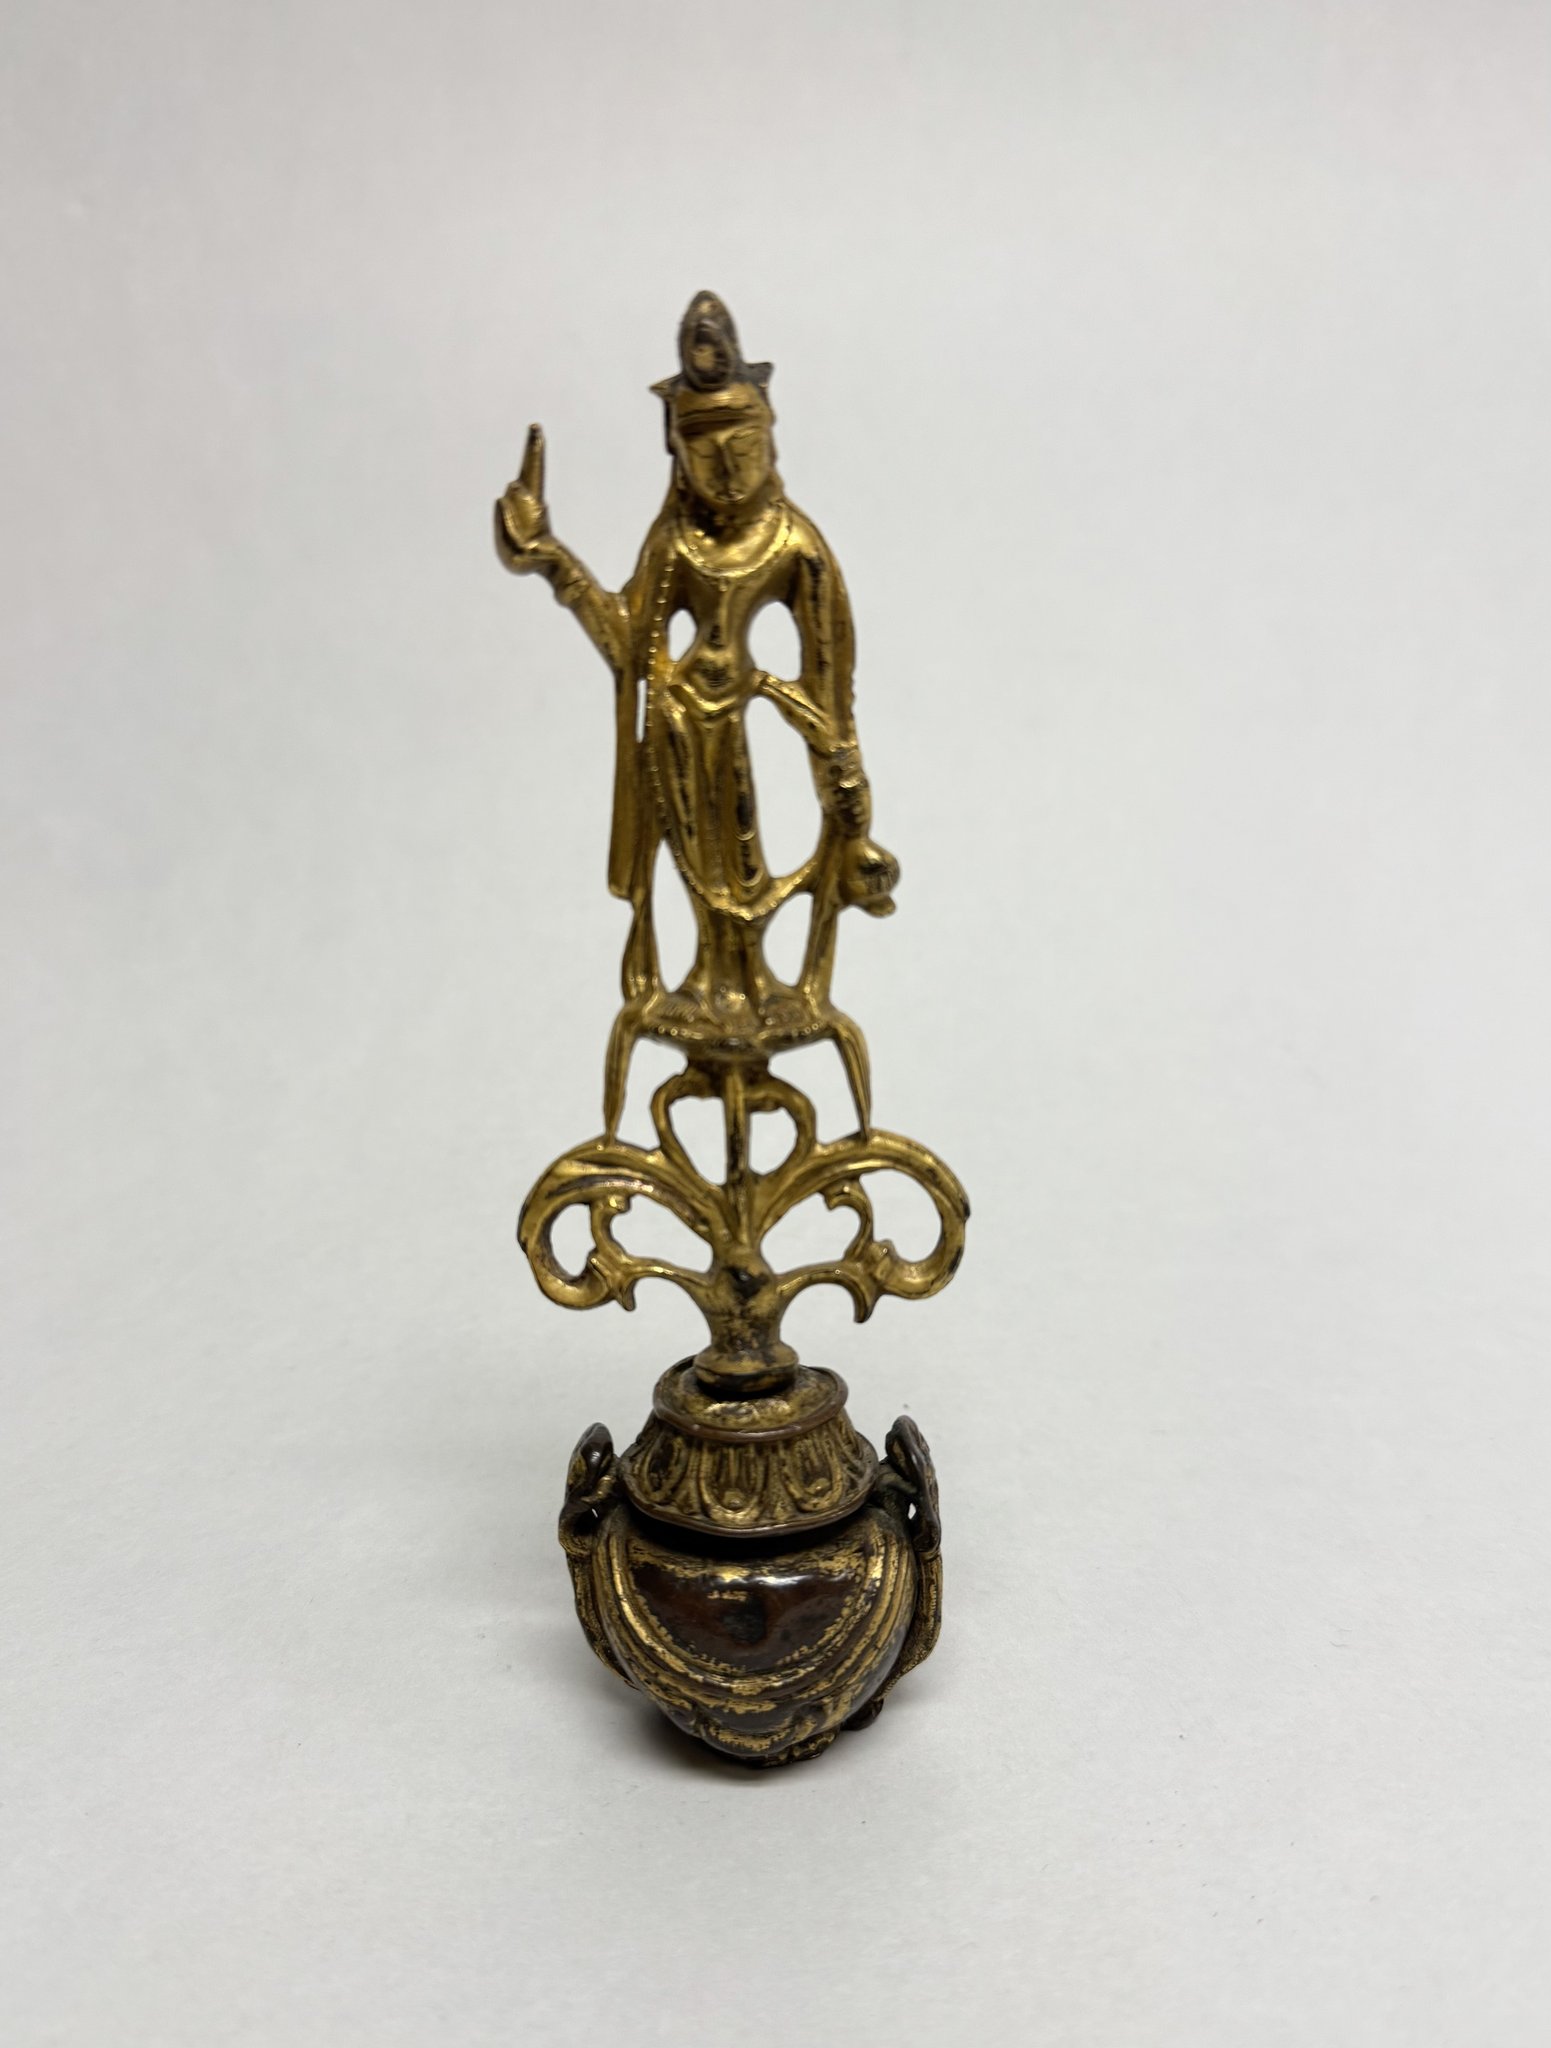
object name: figure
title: Bodhisattva Avalokiteshvara (Guanyin)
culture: chinese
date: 618-907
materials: gilt bronze